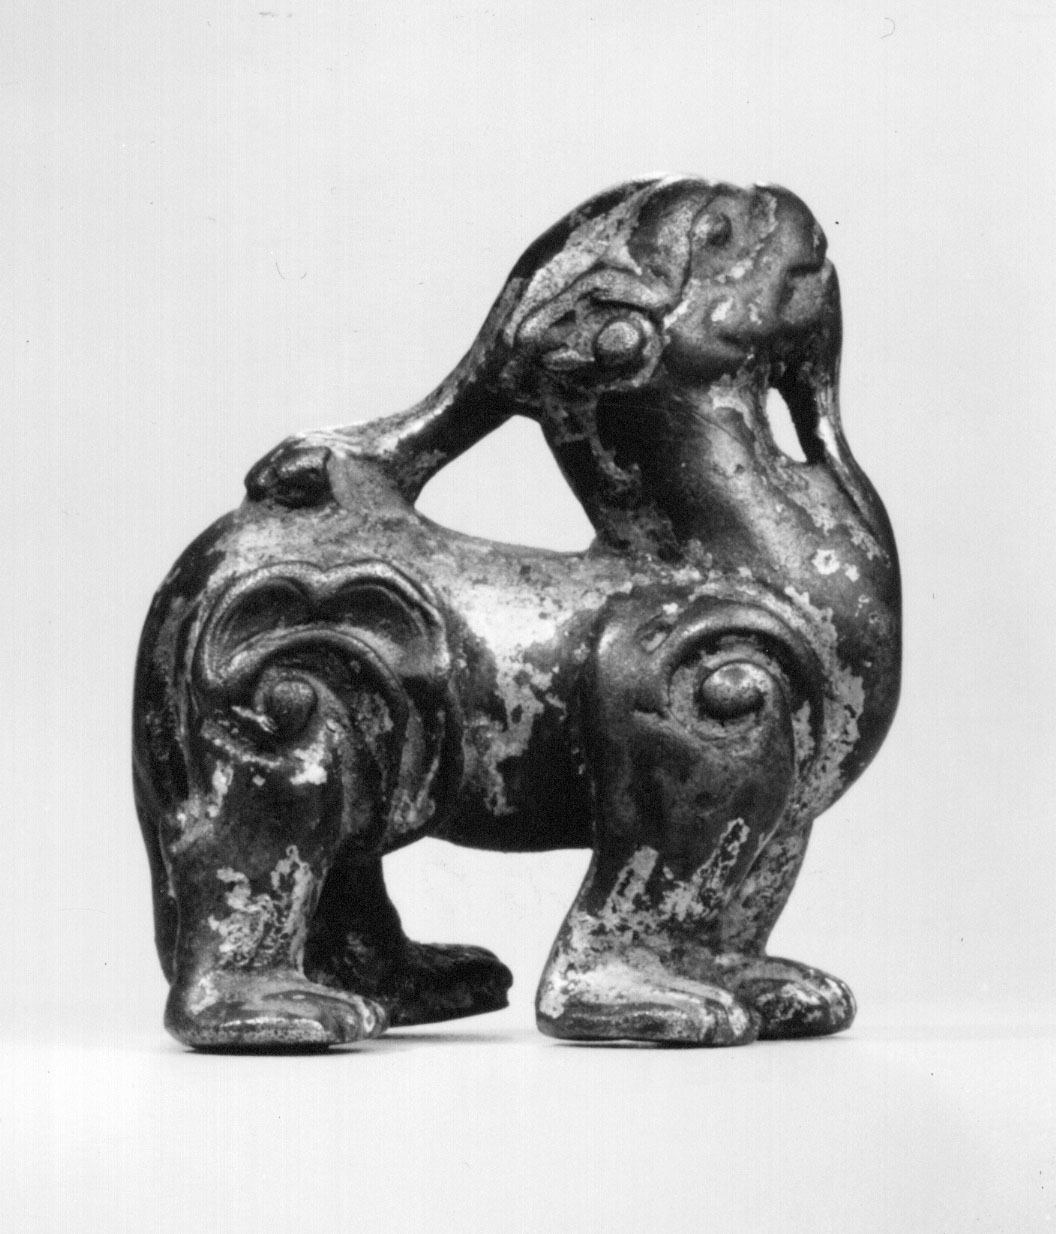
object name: figure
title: Chimera (Bixie)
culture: chinese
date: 201-600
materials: gilt bronze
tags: lions